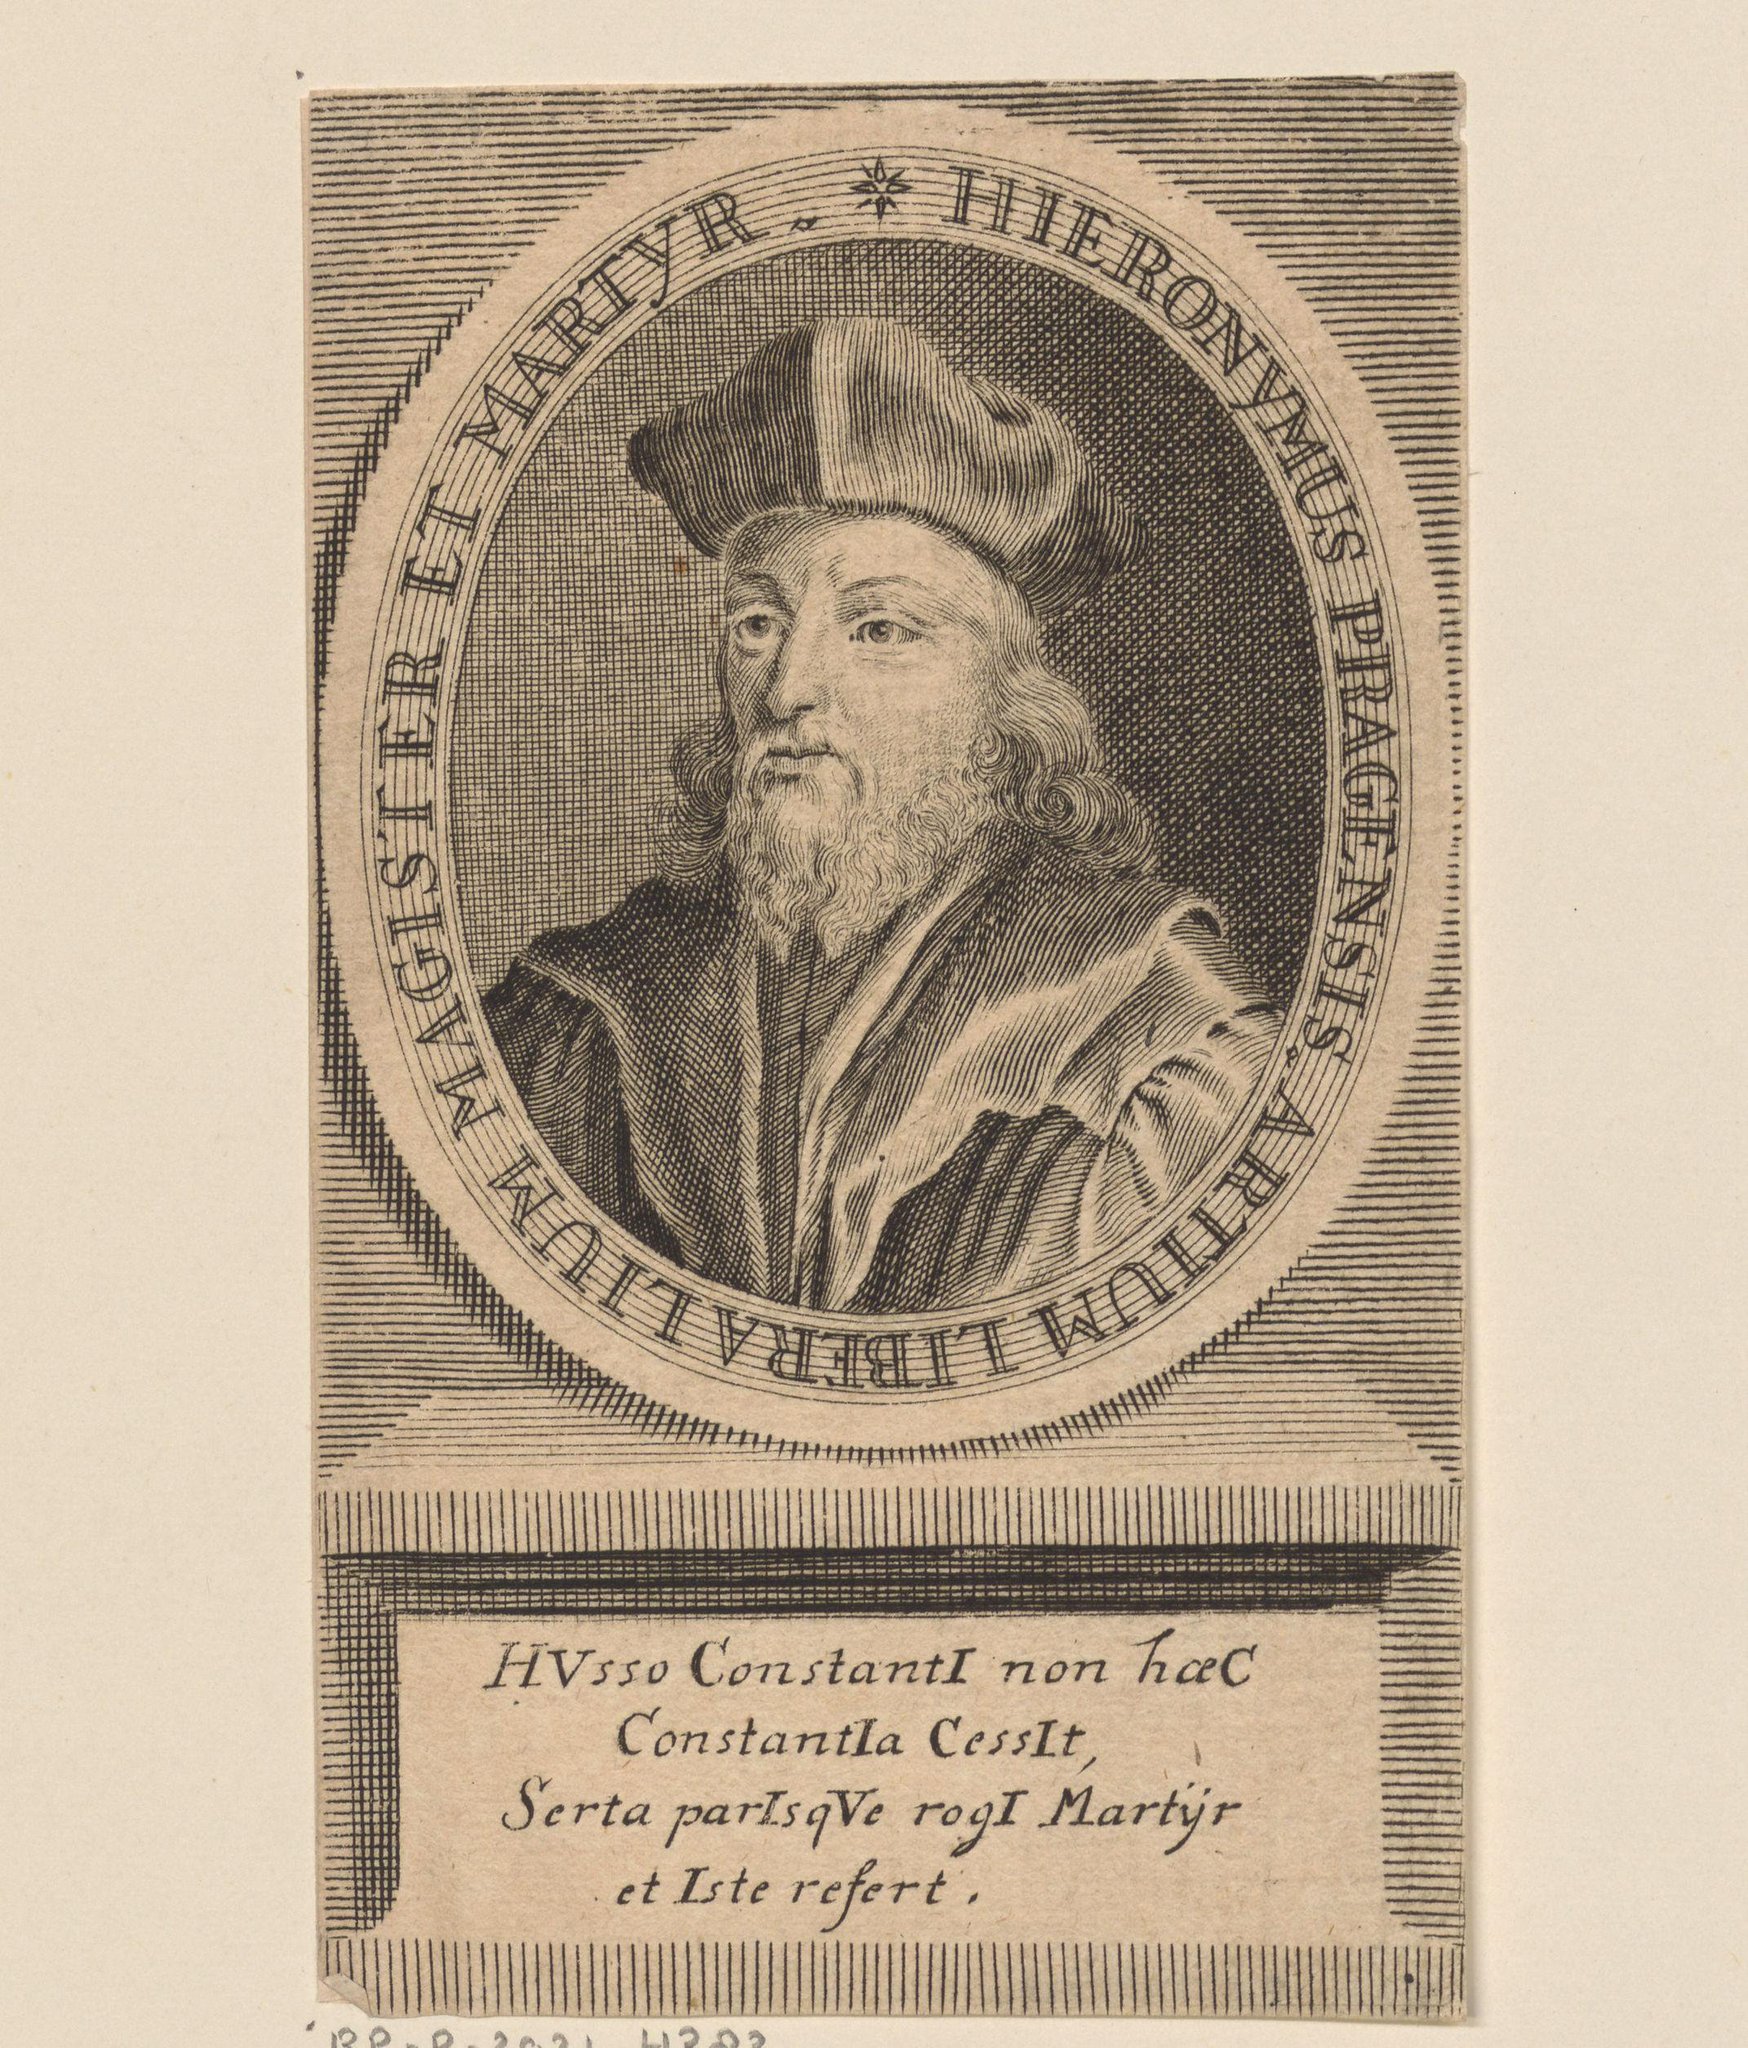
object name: print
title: Portret van Hiëronymus van Praag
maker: Anonymous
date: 1700-1749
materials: paper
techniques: engraving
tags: theologian, historical persons